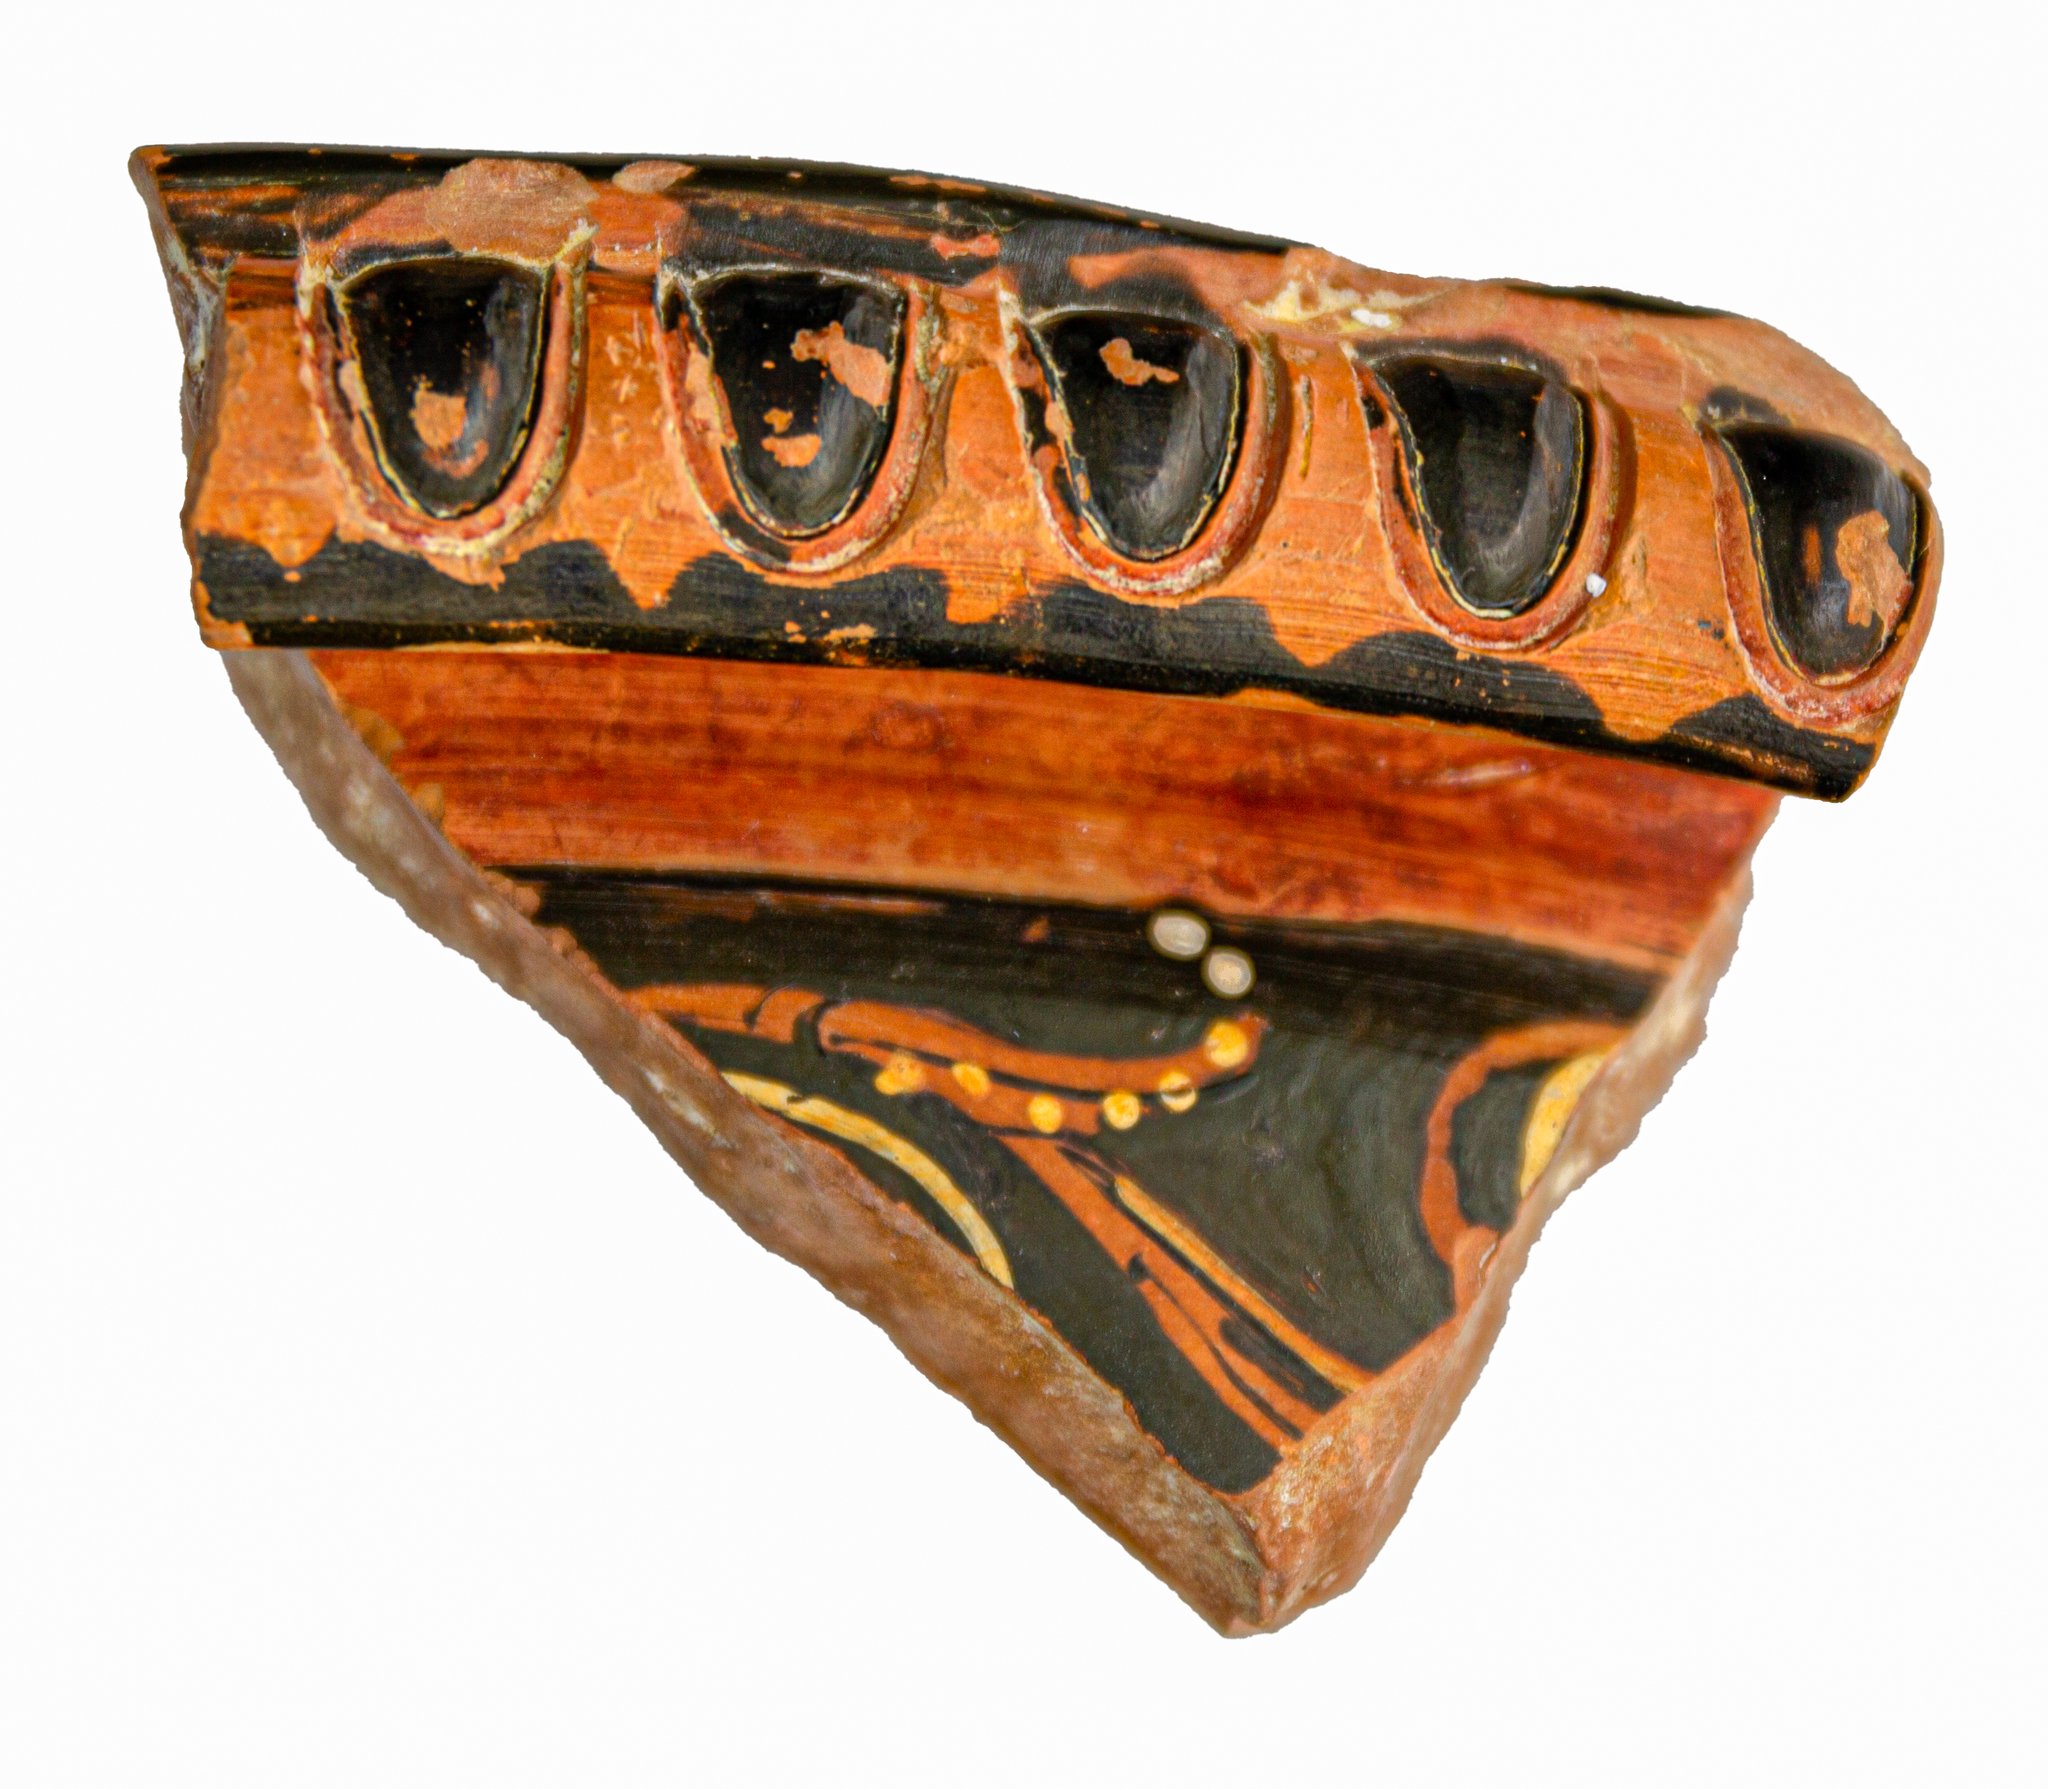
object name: volute krater fragment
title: Volute-krater fragment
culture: greek, south italian, apulian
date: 360-340 BCE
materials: terracotta